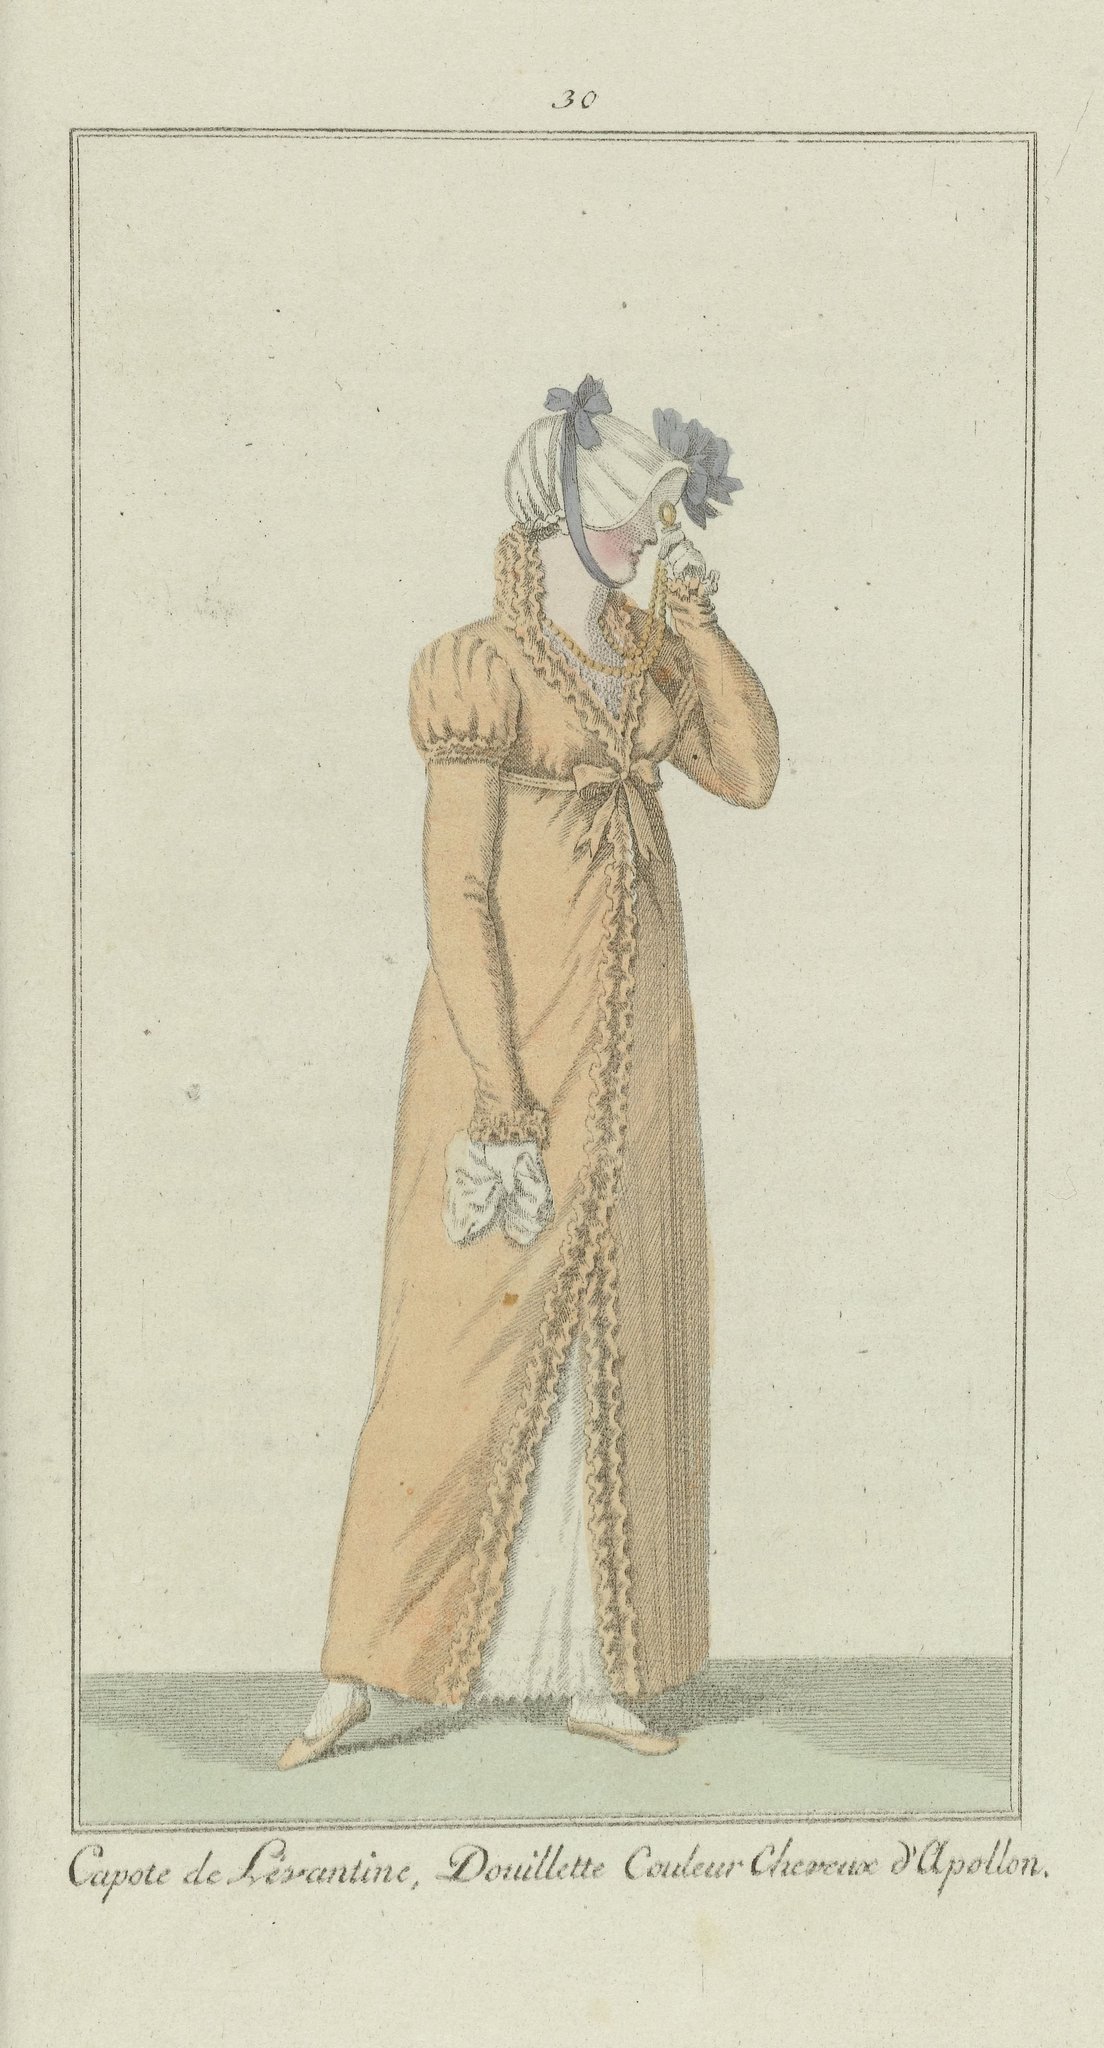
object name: fashion print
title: Elegantia, of tijdschrift van mode, luxe en smaak voor dames, December 1807, No. 30: Capote de Levantine...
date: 1807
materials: paper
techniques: engraving, hand coloring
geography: amsterdam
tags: handkerchief (+ women's clothes), head-gear (capote) (+ women's clothes), monocle, single lorgnette - aa - female human figure, coat (+ women's clothes), fashion plates, shoes, sandals (+ women's clothes), sleeves (+ women's clothes)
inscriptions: caption: ‘Capote de Lévantine. Douillette Couleur Cheveux d'Apollon’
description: Volgens de begeleidende tekst (p. 392): 'Doeillette' van kastanjebruine zijde ('couleur cheveux d'Apollon'), gegarneerd met een brede 'froncé'. Mouwen 'en amadis'. 'Capote de lévantine', met lilakleurige garnering. Prent uit het modetijdschrift Elegantia, of tijdschrift van mode, luxe en smaak voor dames 1807-1814 (onderbroken door de periode 1811-1813).